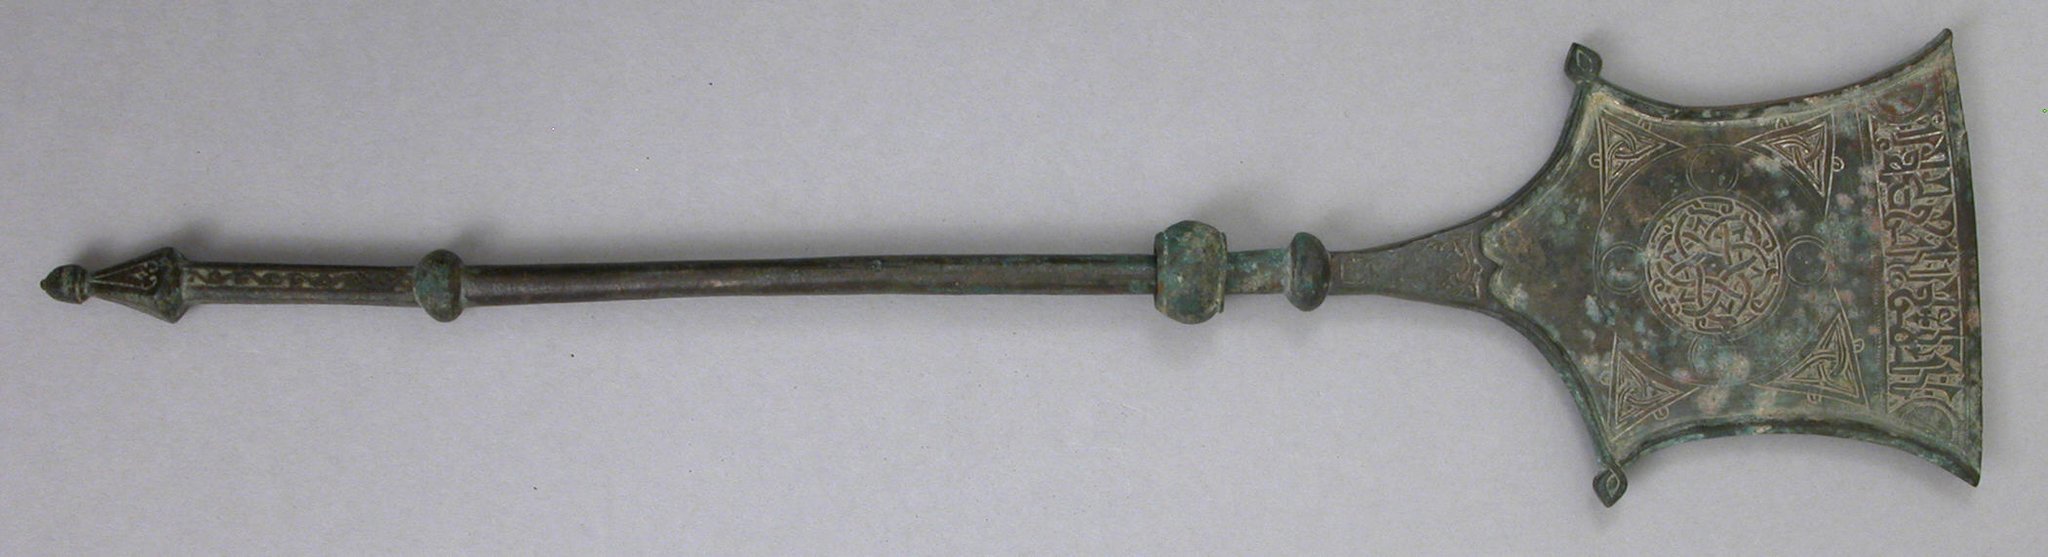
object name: shovel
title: Rice Server Inscribed in Arabic with Good Wishes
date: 1101-1200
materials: brass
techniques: casting, chasing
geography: iran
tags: arabic